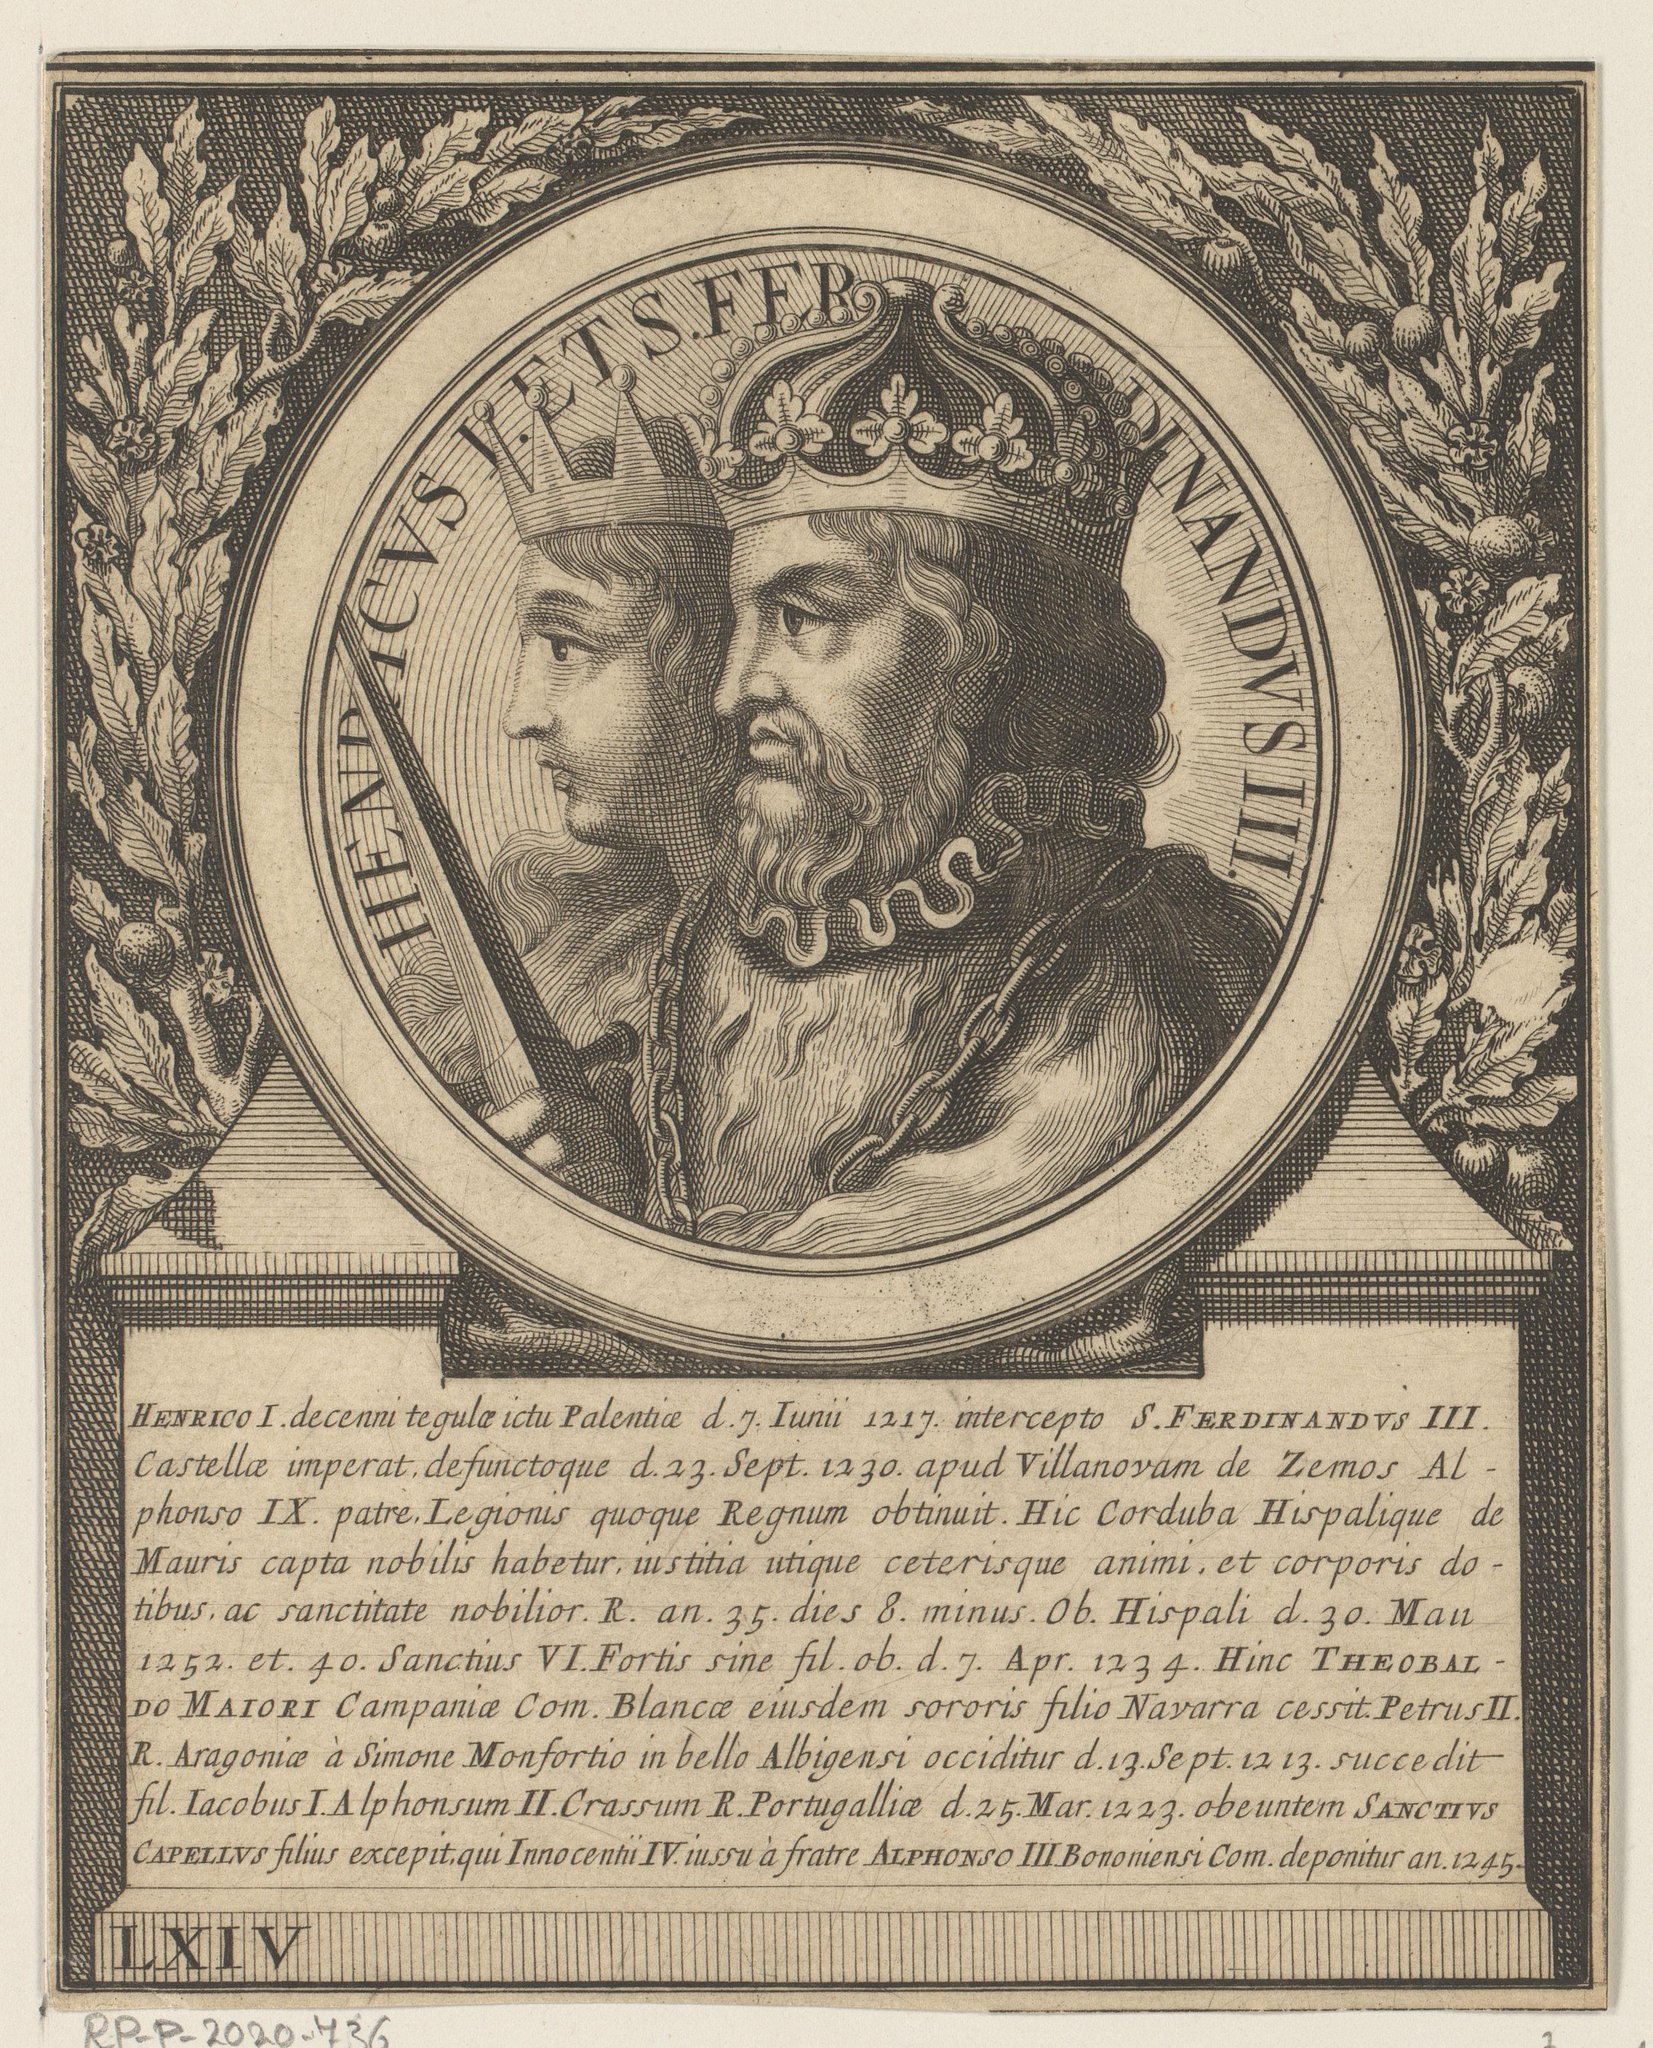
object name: print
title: Portret van Hendrik I en Ferdinand III, koningen van Castilië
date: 1698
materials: paper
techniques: engraving, etching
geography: paris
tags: historical persons, ruler, sovereign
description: Portret afkomstig van een grote prent, getiteld 'Series Chronologica et Imagines Regum Hispaniae ab Ataulpho ad Carolum II', bestaande uit meerdere bladen die samengevoegd konden worden, uitgegeven door Petrus de la Tour in 1698.